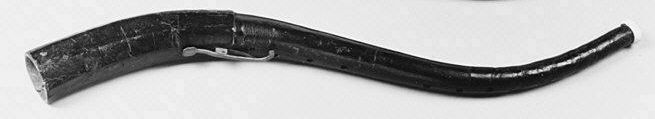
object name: tenor cornetto in g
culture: french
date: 1601-1700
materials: leather, wood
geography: france